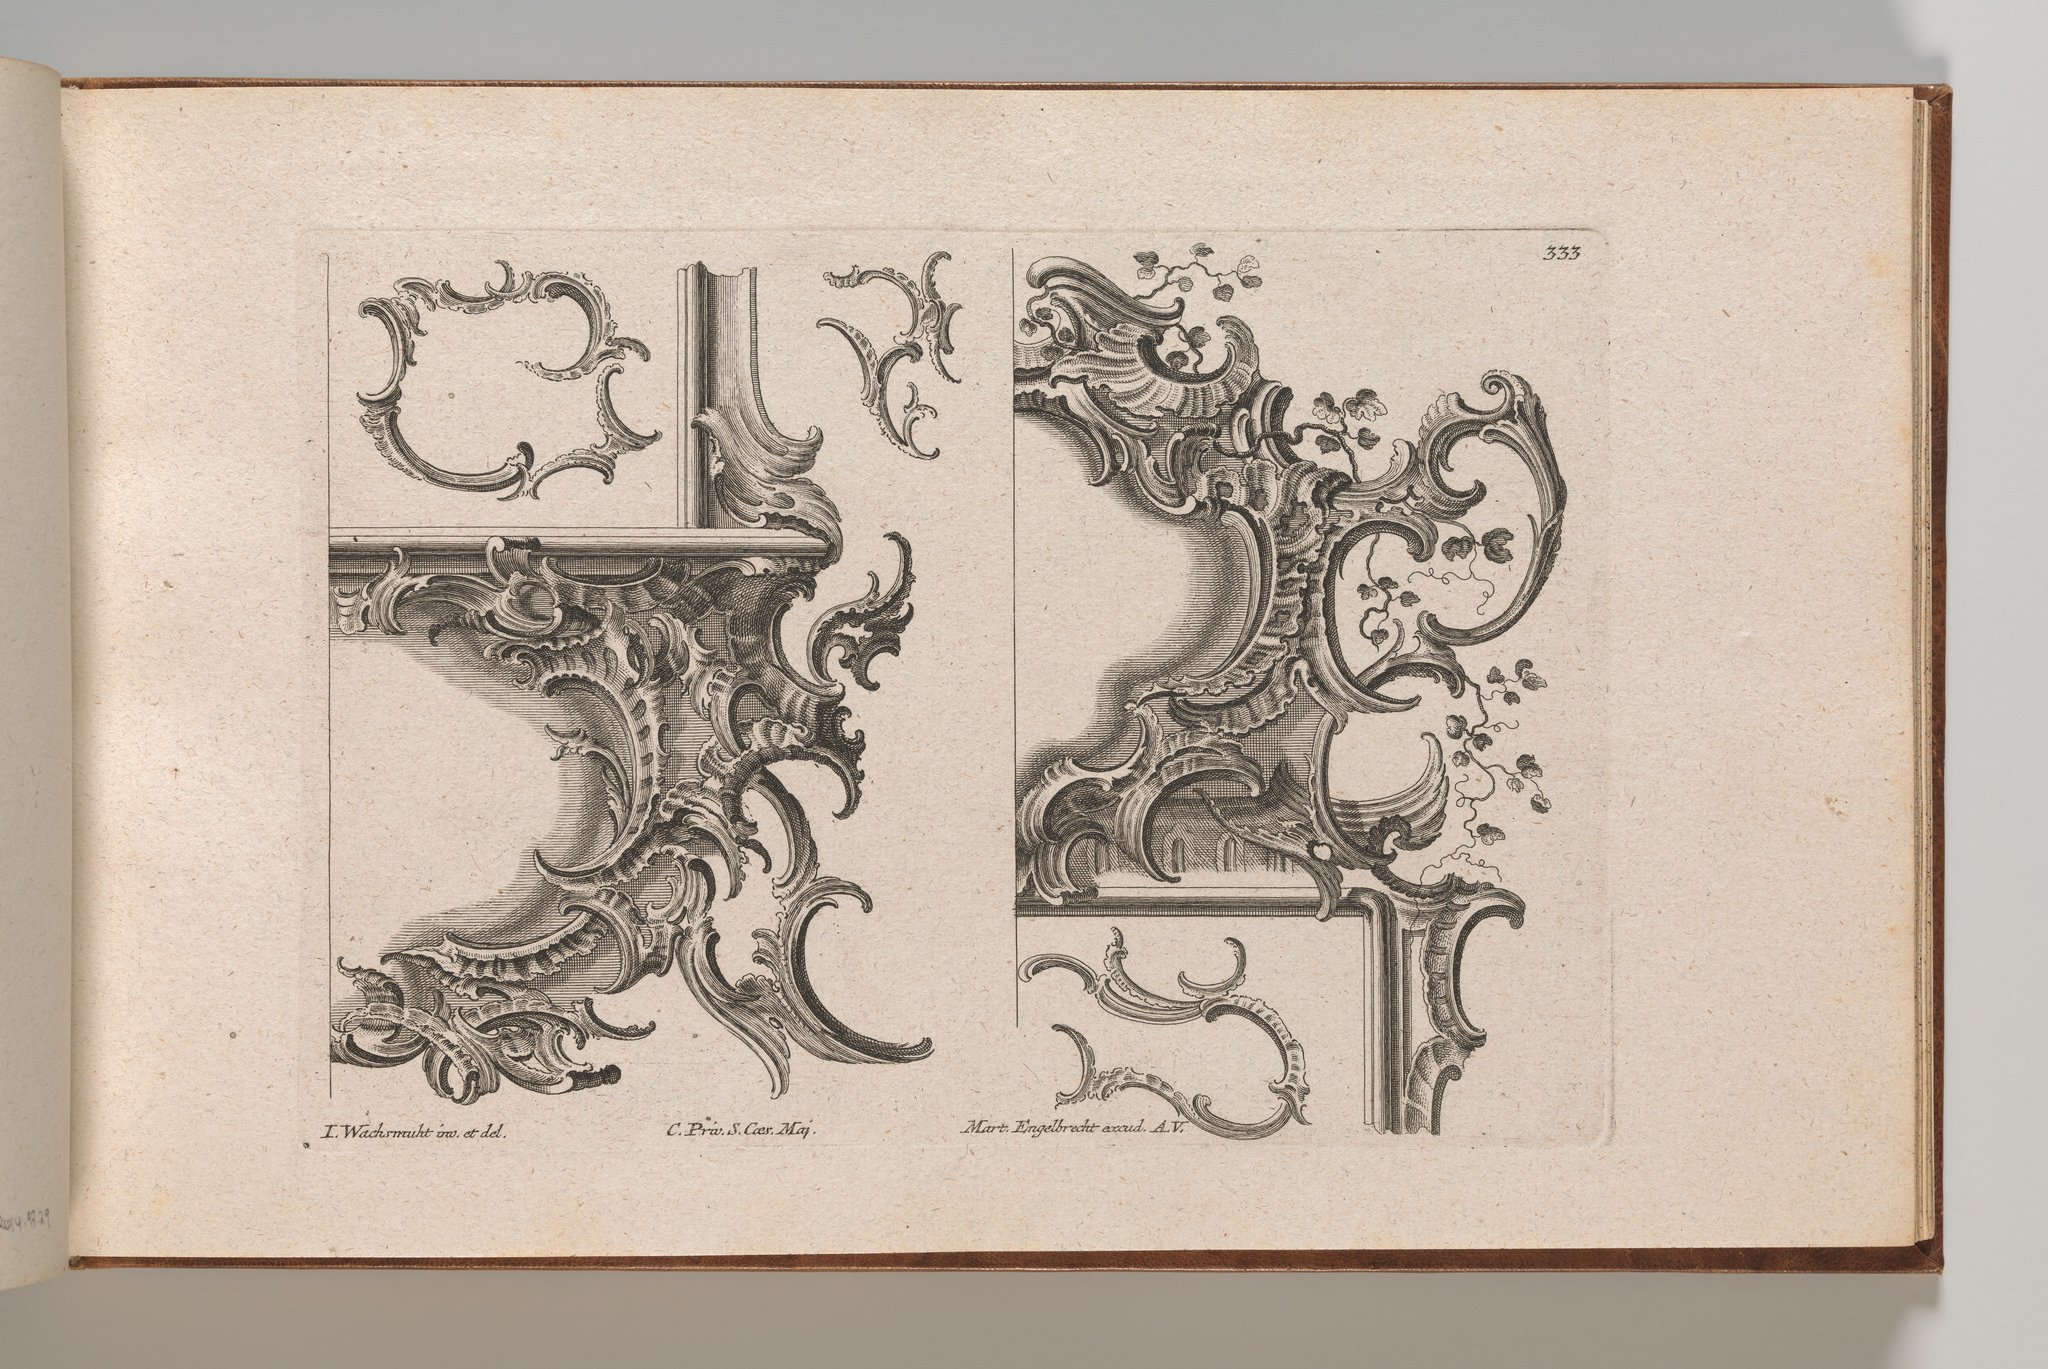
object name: album print ornament architecture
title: Suggestion for the Decoration of Lower Right and Top Right of a Framel, Plate 4 from an Untitled Series with Rocailles Ornaments for Window, Pier Glass and Door Frames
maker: jeremias wachsmuth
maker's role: artist and engraver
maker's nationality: german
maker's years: 1712-1771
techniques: etching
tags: ornament